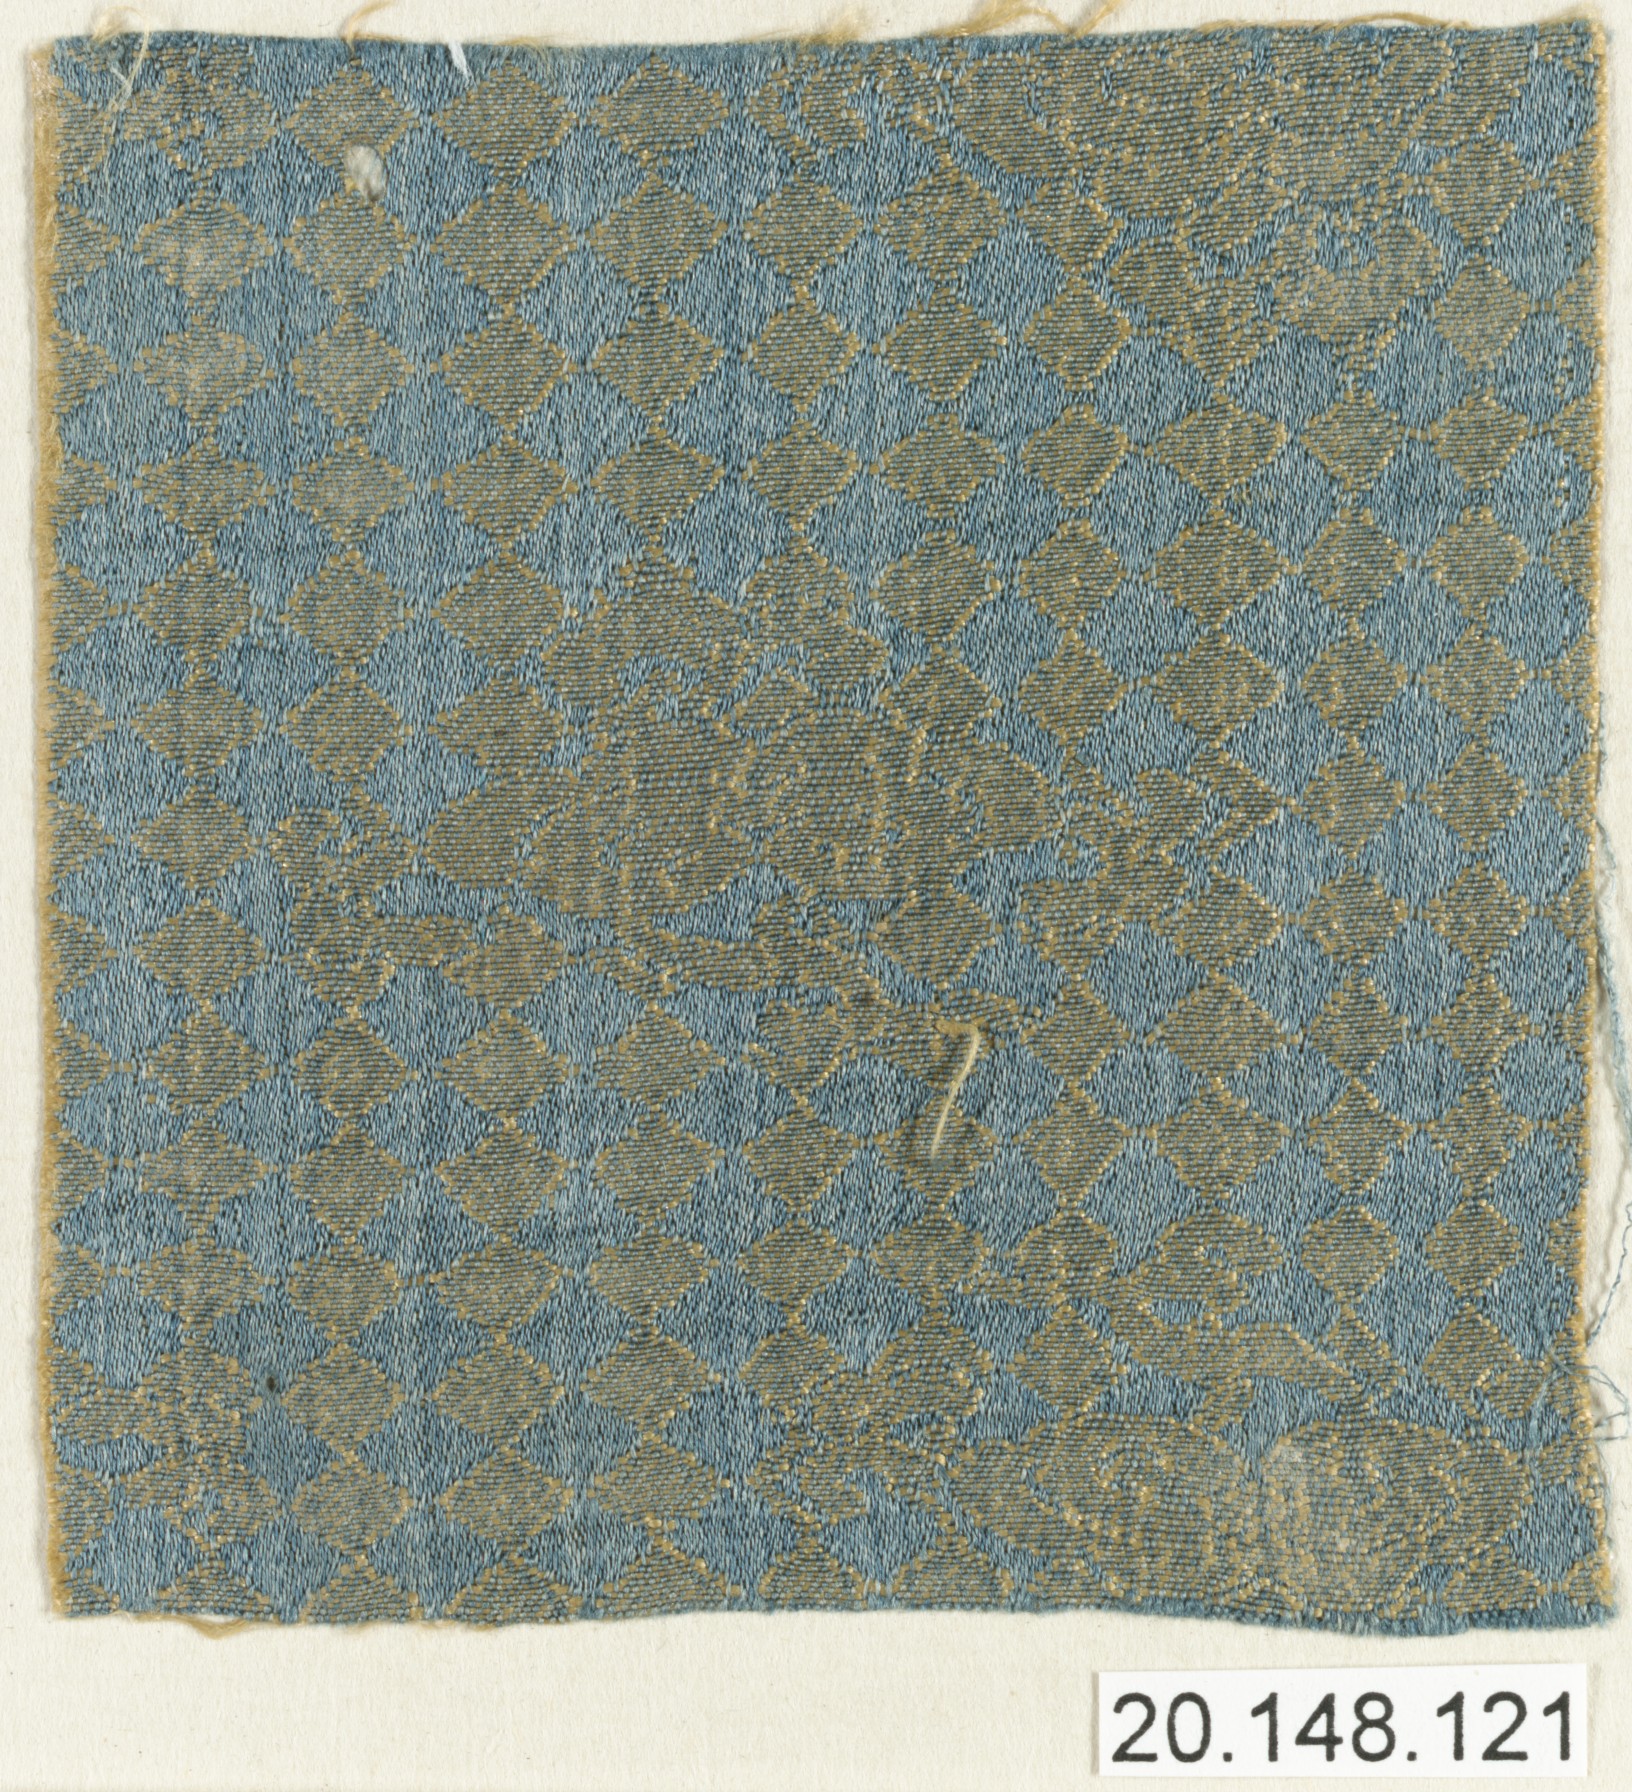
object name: piece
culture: chinese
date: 1701-1800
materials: silk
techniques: compound weave